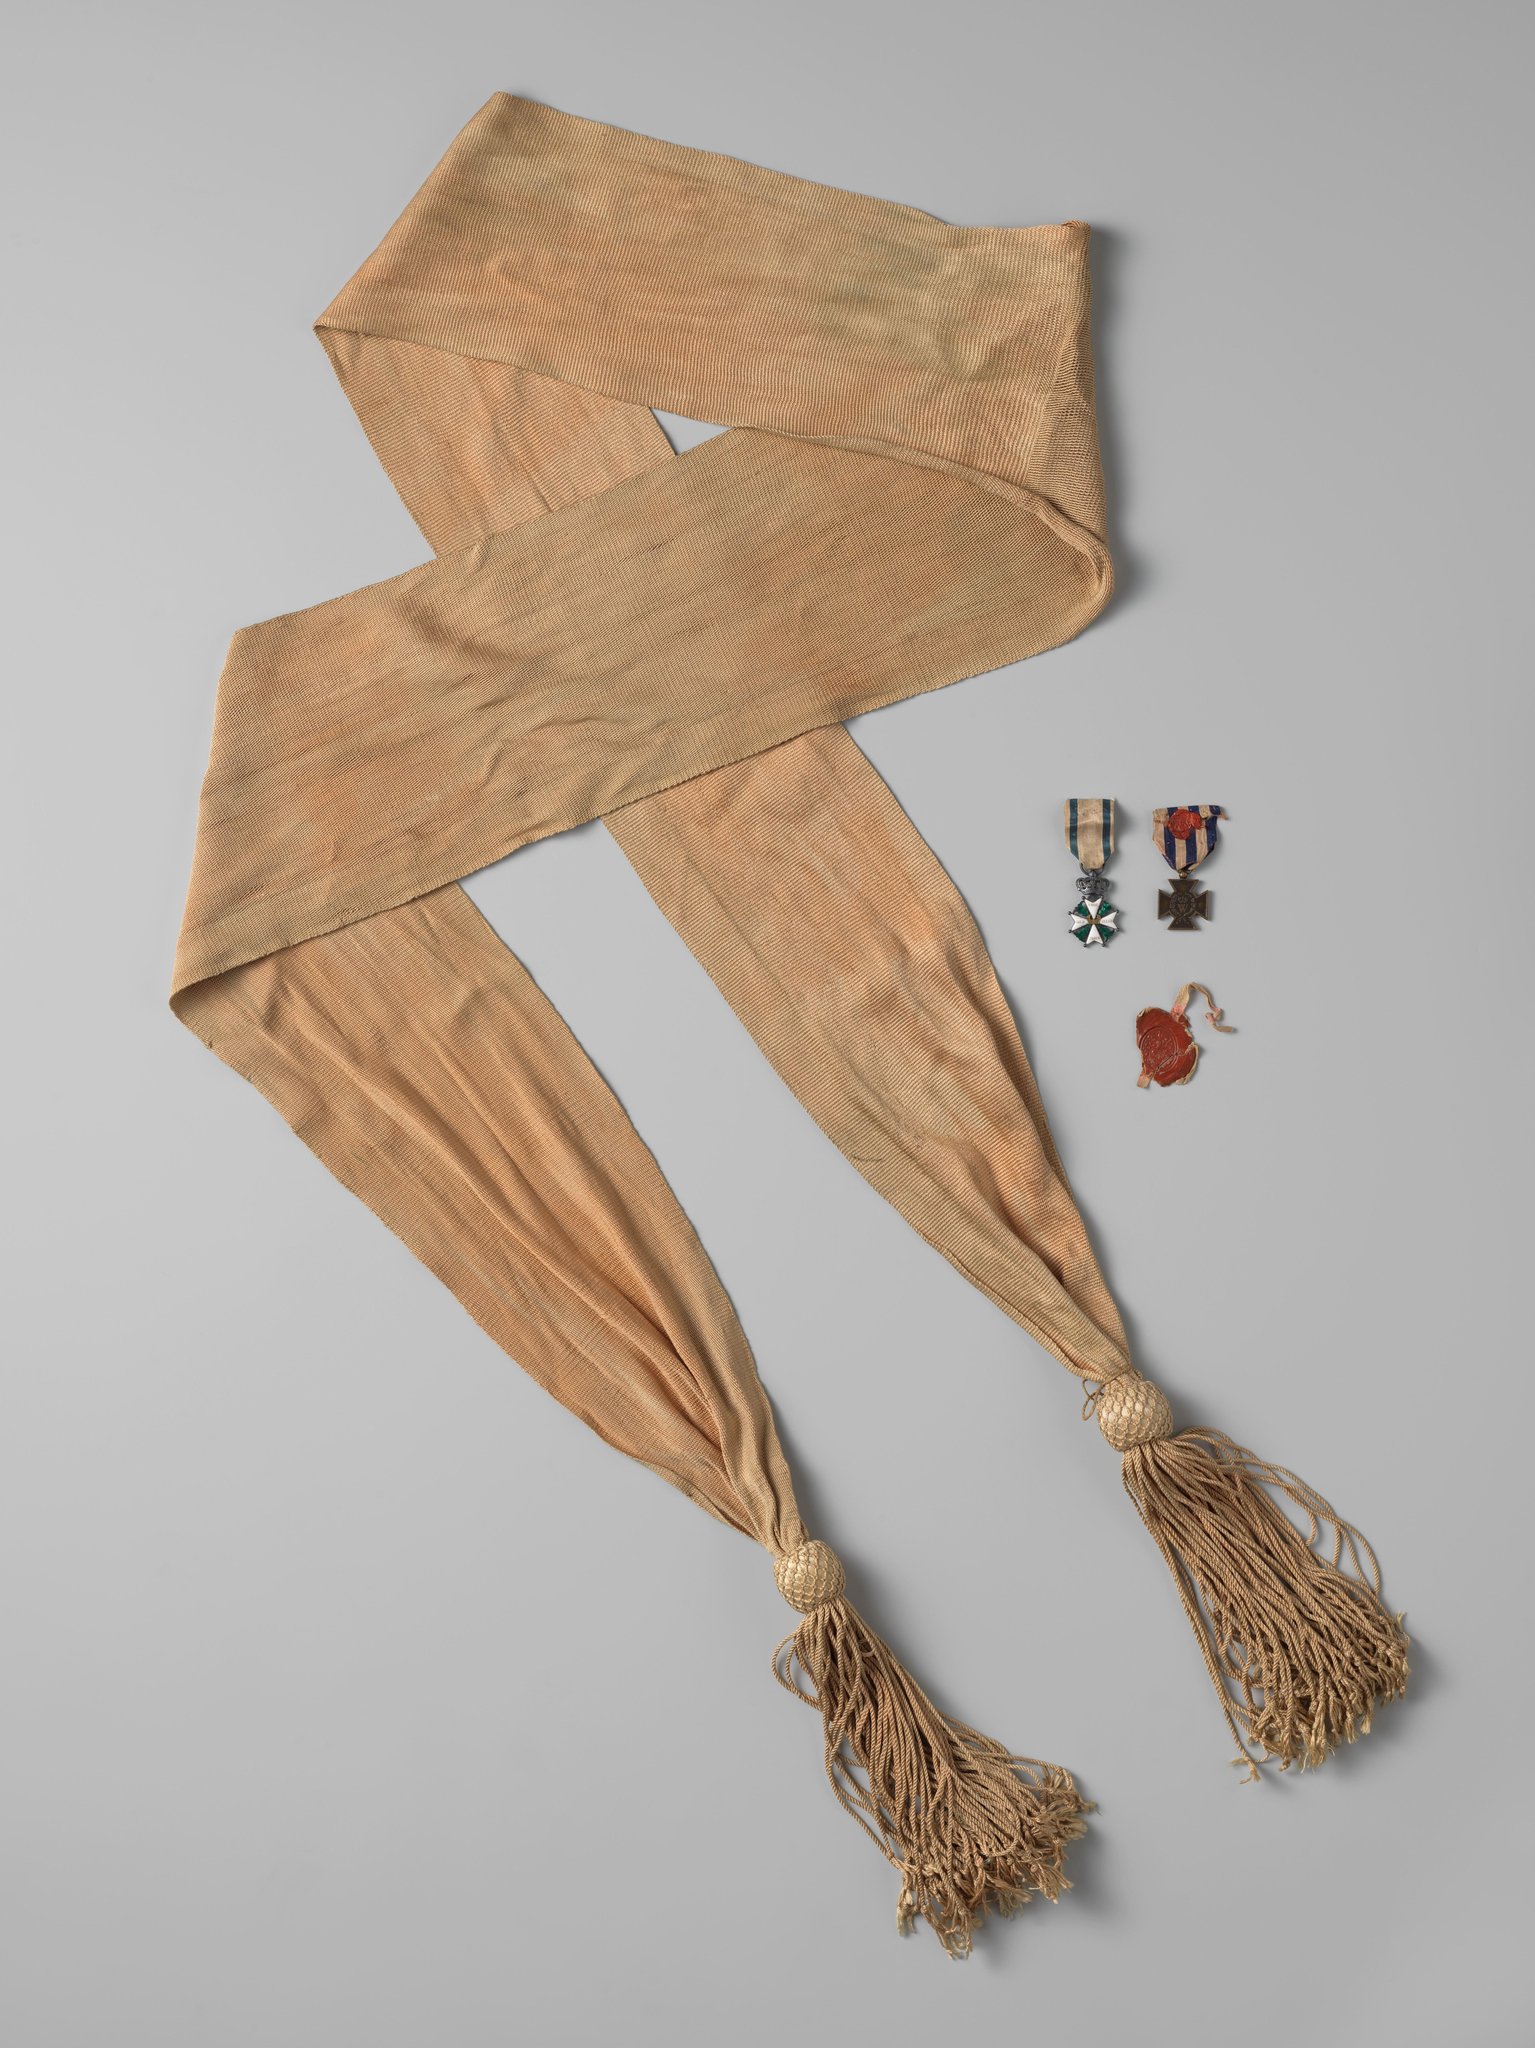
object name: sash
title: Sjerp met de Militaire Willemsorde en Metalen Kruis van Generaal baron Chassé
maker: Anonymous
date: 1830-1832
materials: silk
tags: david hendrik baron chassé, antwerp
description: Oranje zijden sjerp met de Militaire Willemsorde en Metalen Kruis. Behoord hebbende aan baron D.H. Chassé, luitenant generaal opperbevelhebber van de Citadel van Antwerpen.